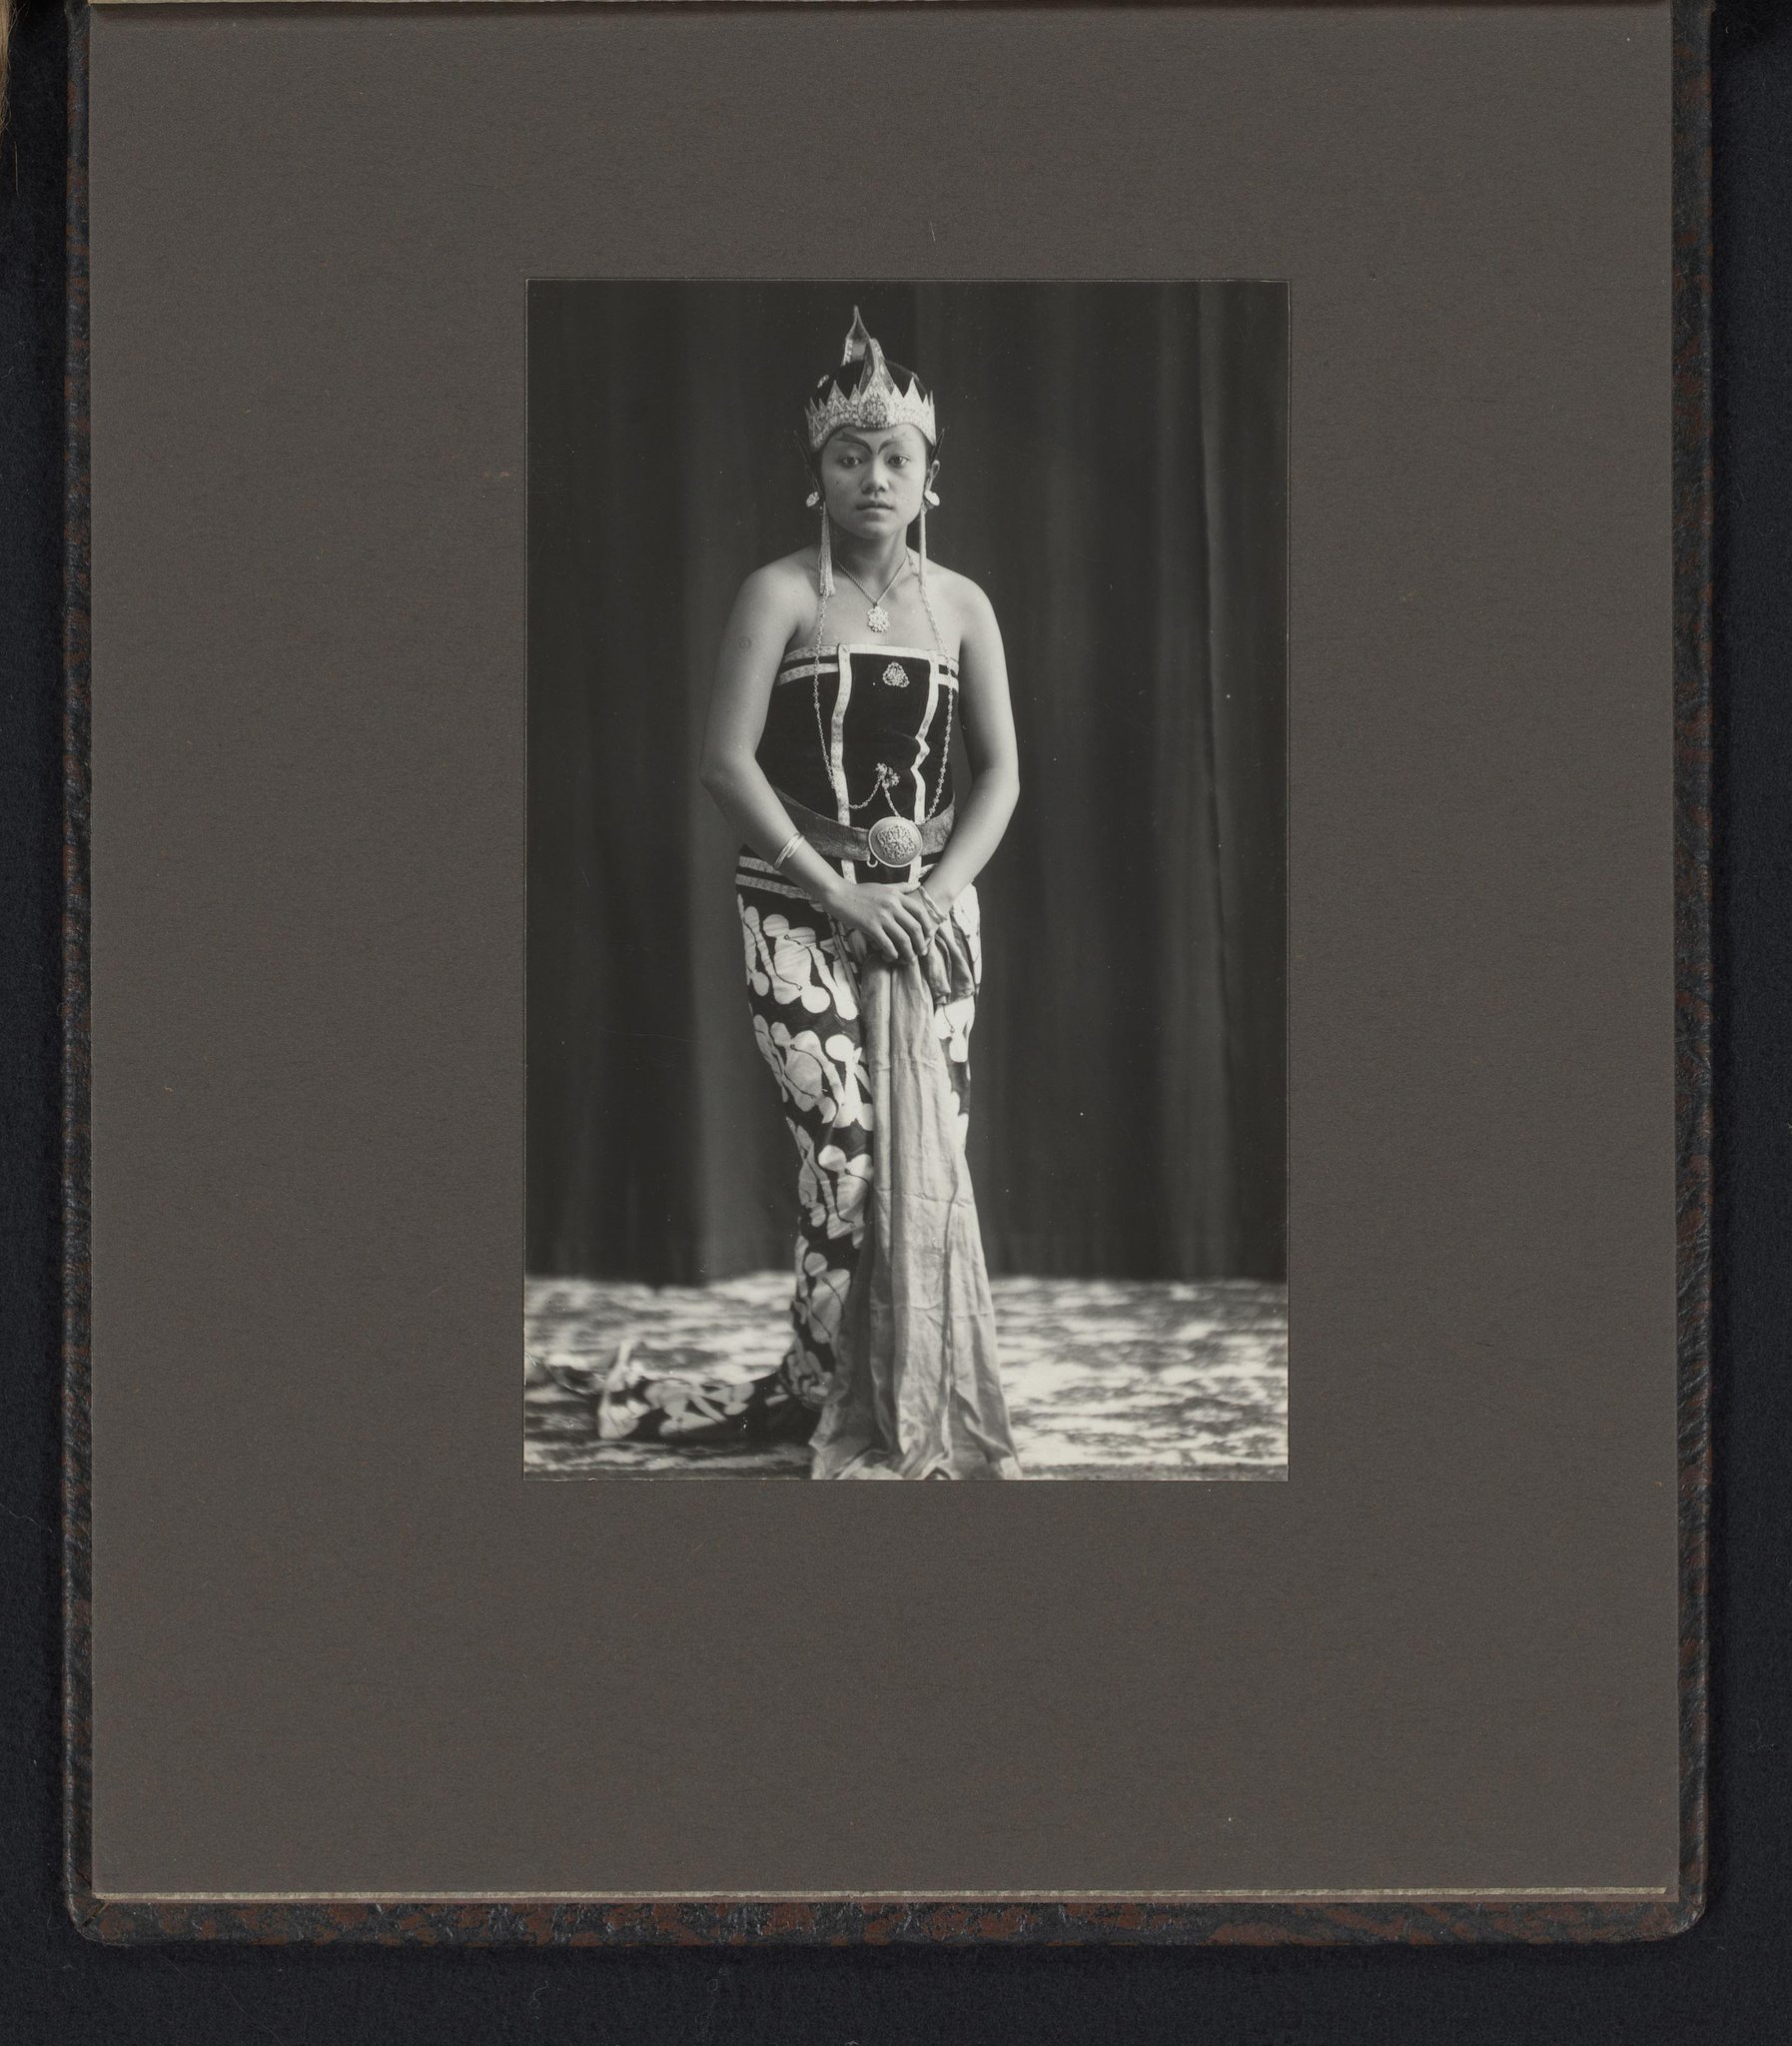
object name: album leaf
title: Portret van een Javaanse danseres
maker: adeline andrea. du celliée muller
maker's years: 1899-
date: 1930-1940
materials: paper, photographic support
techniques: gelatin silver print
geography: dutch east indies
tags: adult woman, portrait of dancer, dutch east indies, the